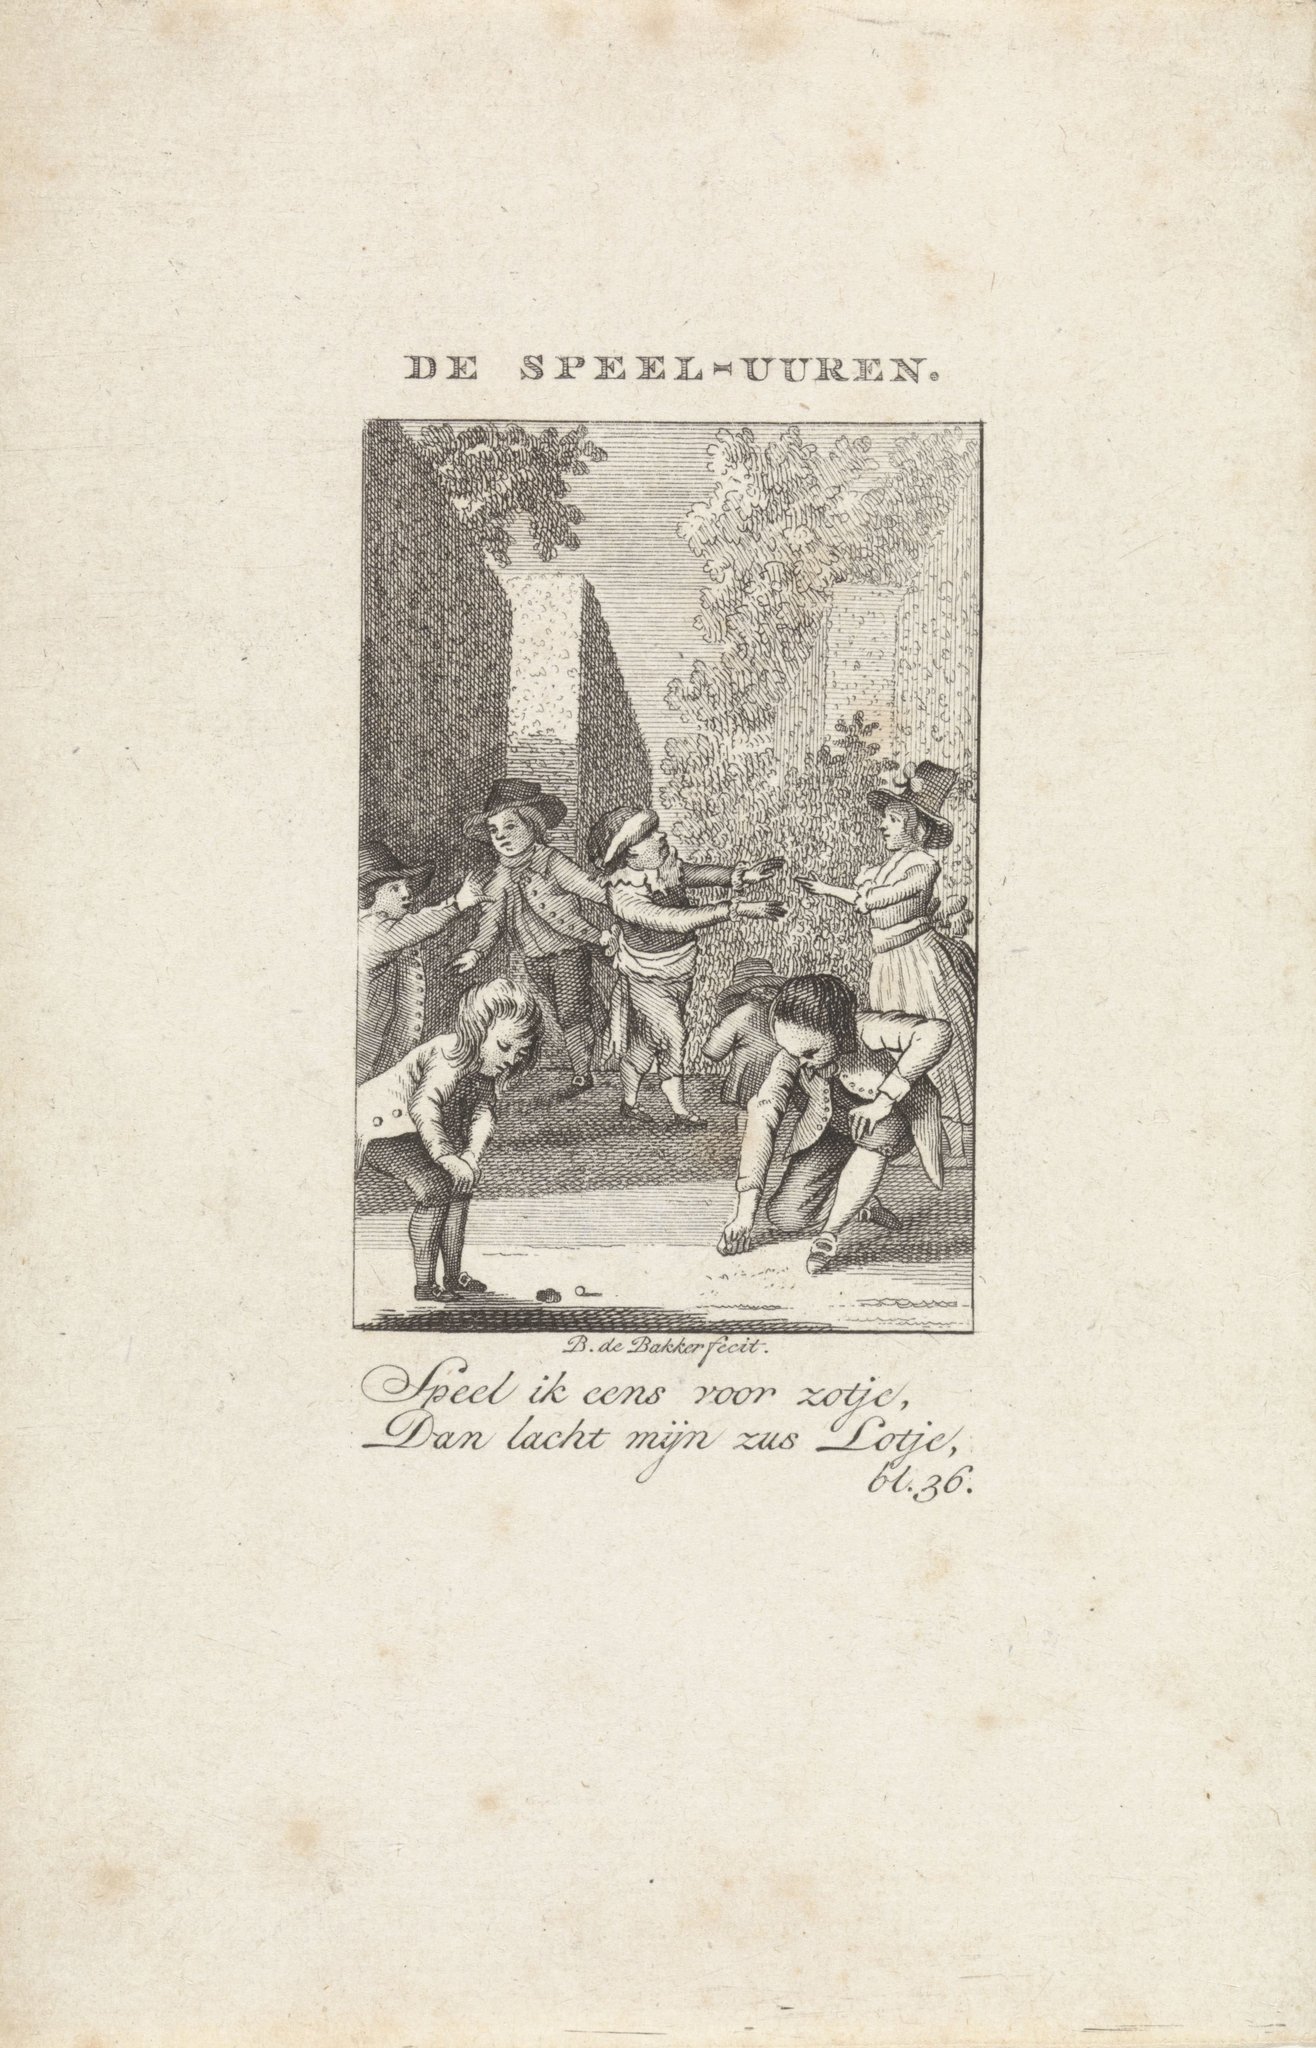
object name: print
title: Kinderpligt en zinnebeelden 2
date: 1789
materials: paper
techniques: engraving, etching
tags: children's games and plays, child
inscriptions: collector's mark: Lugt 2228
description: Prent uit: Hazeu, Johannes Cornelisz., Agt kunstplaaten behoorende tot de Kinderpligt en zinnebeelden, Willem van Vliet (uitgever), Amsterdam 1789.